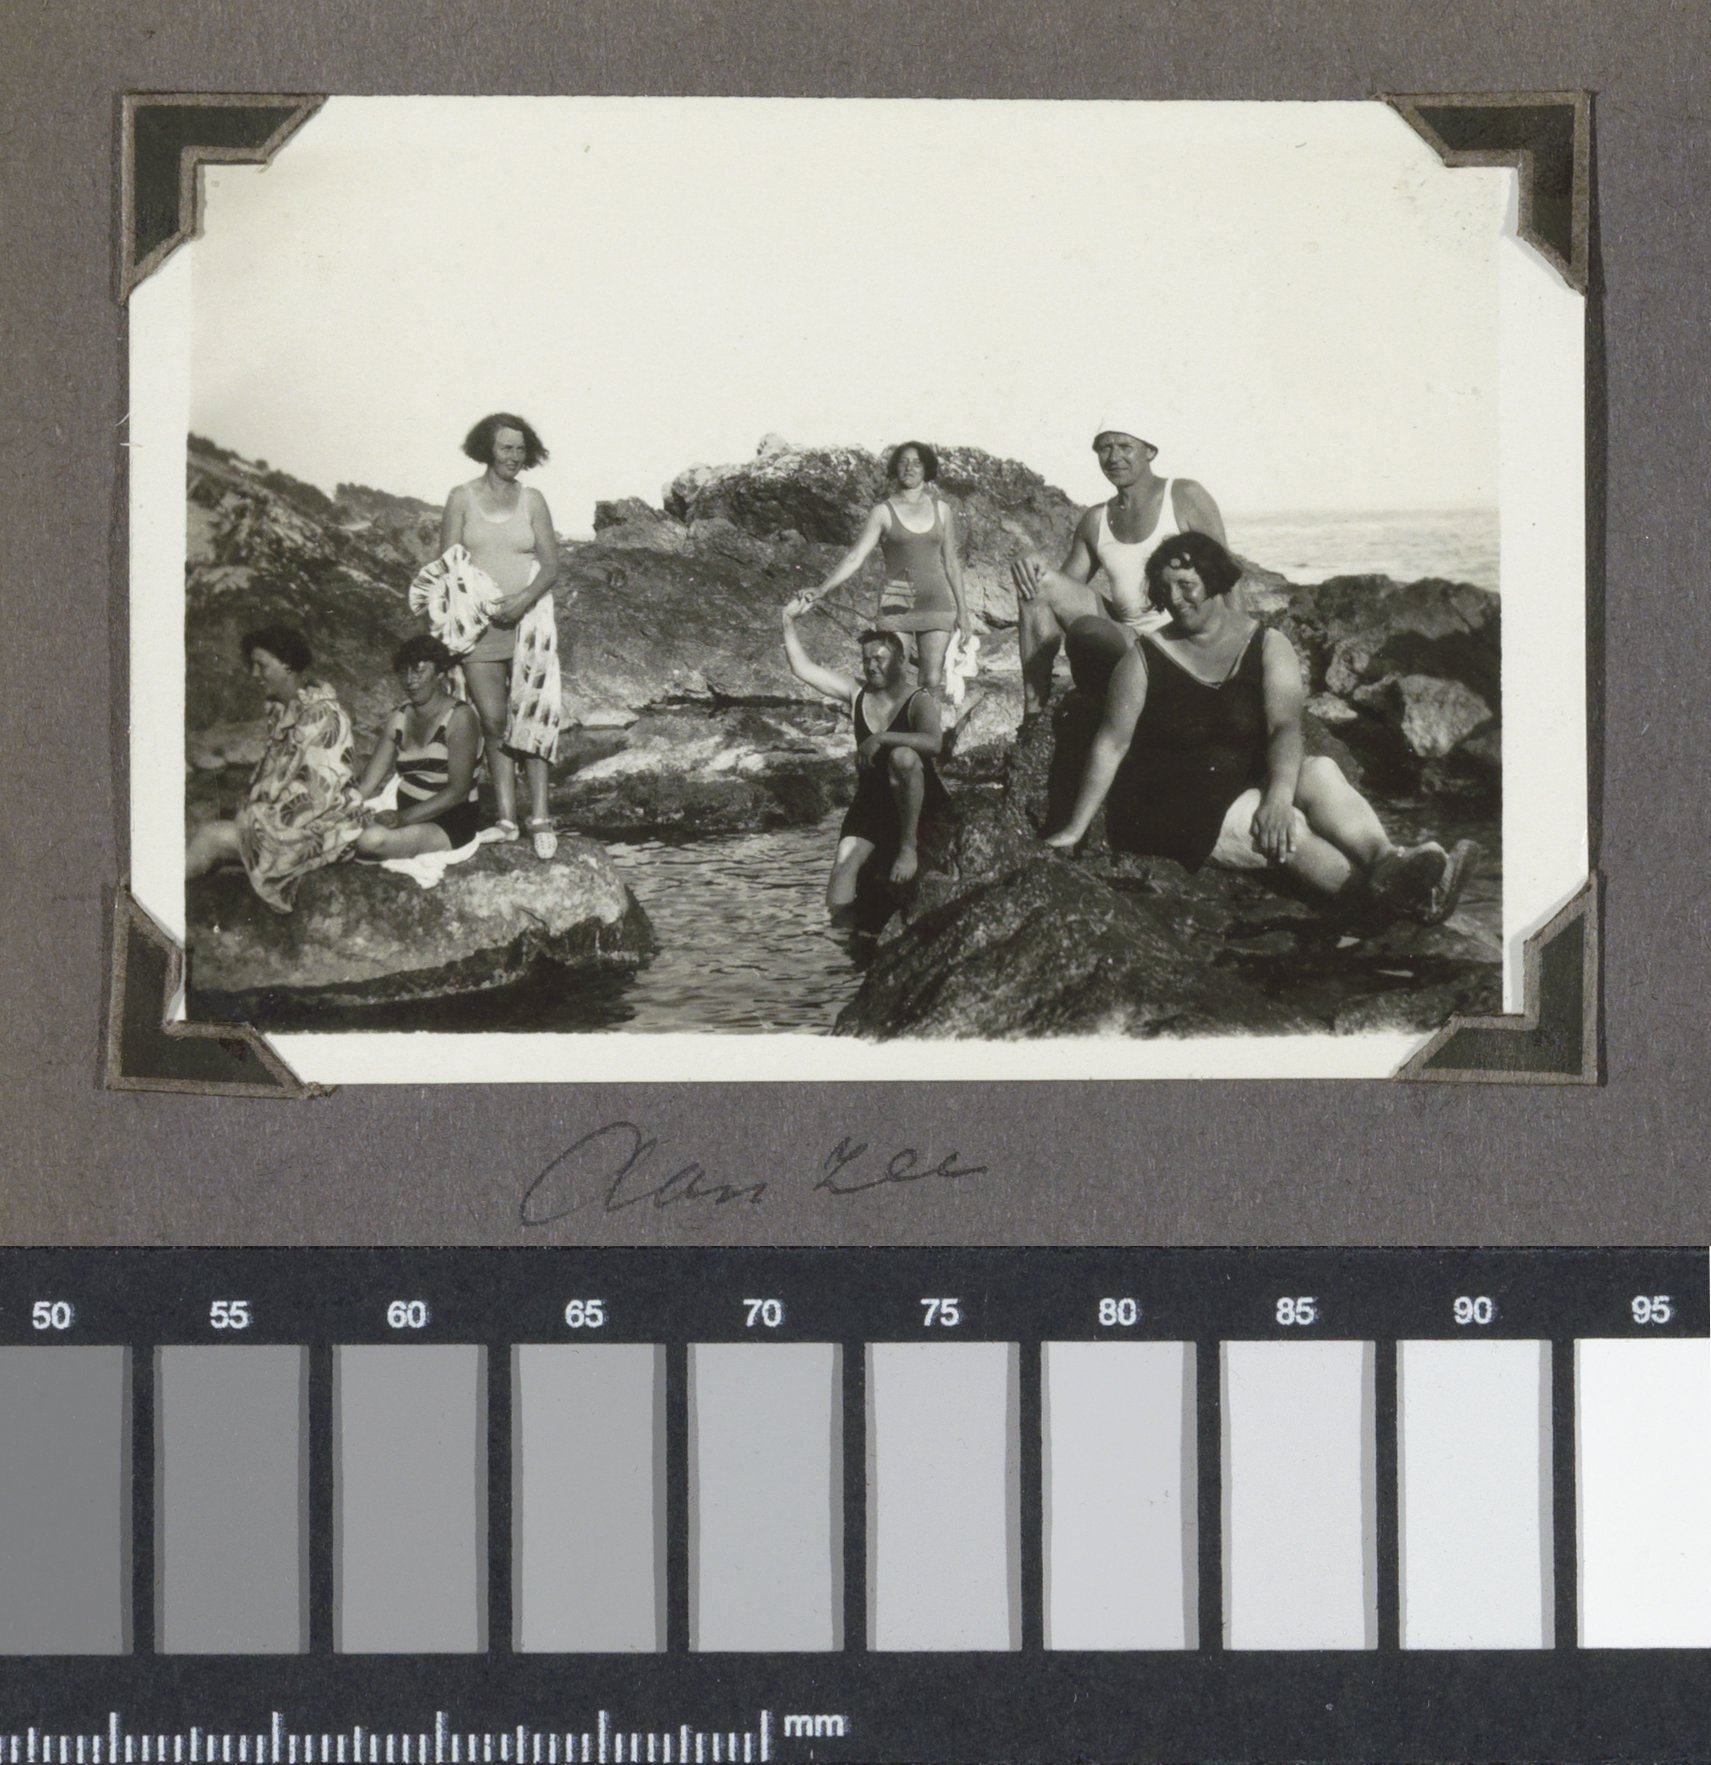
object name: photograph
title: Gezelschap in zwemkleding op een rots bij Roquebrune-Cap-Martin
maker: Anonymous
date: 1930-1935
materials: photographic support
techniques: gelatin silver print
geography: roquebrune-cap-martin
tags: swimming (sport) (+ equipment, outfit (sports, games, etc.))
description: Onderdeel van Fotoalbum met opnames van vakanties in Zuid-Frankrijk.